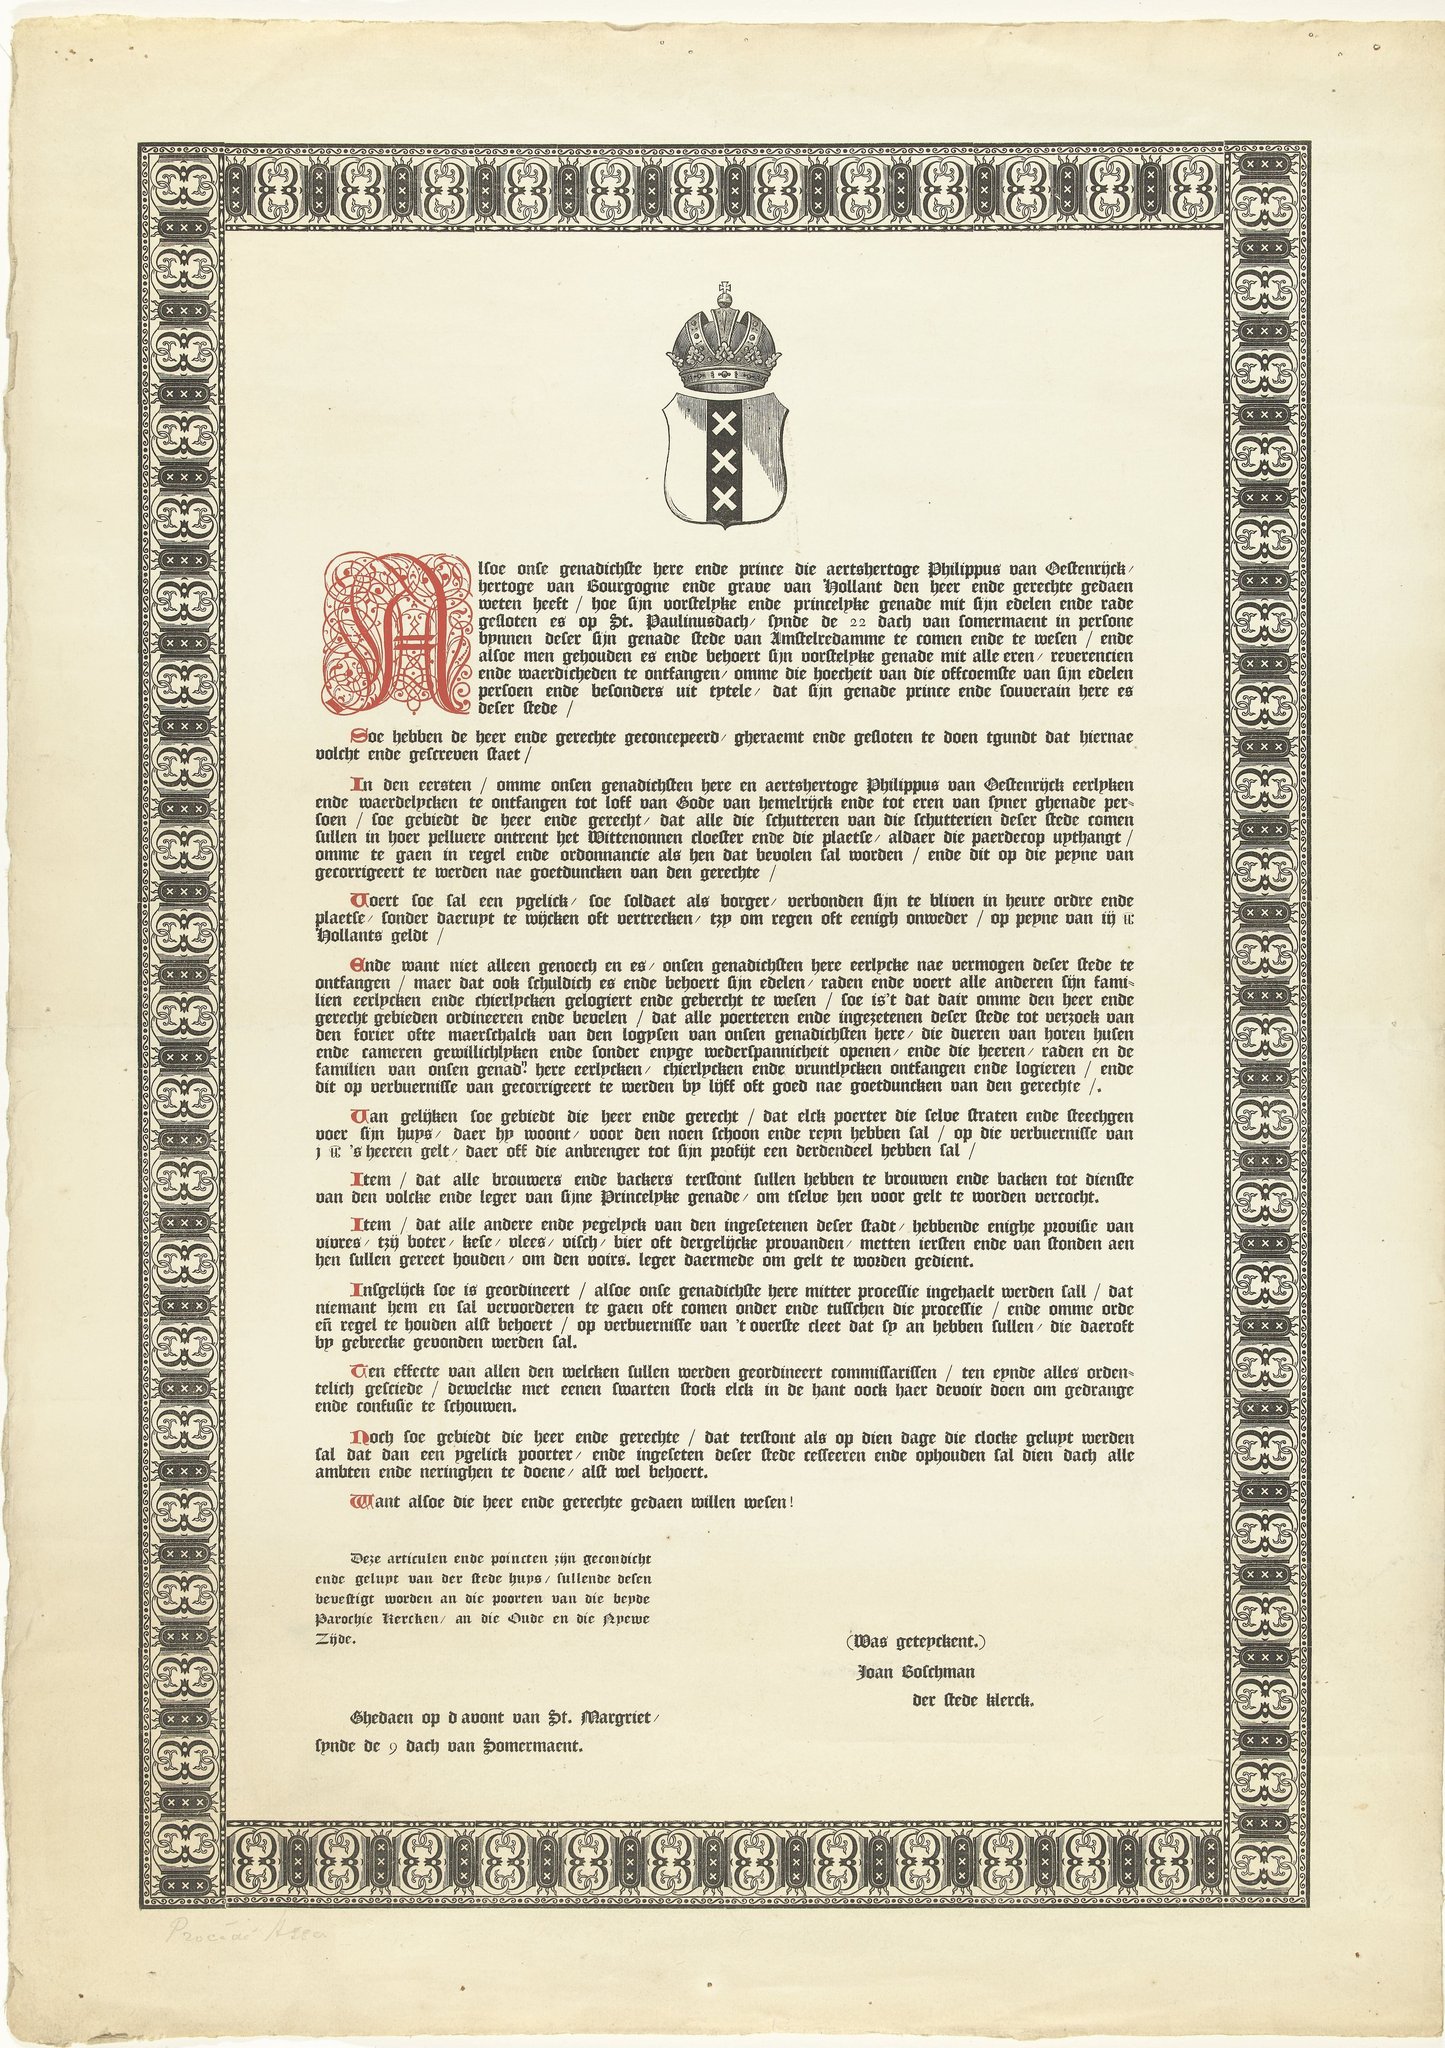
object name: photograph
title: Proclamatie van de stad Amsterdam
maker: a. kroon (fotograaf)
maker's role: fotograaf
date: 1860-1890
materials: paper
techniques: photolithography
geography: netherlands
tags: announcement, proclamation of laws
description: Reproductie volgens het fotolithografisch procédé Asser. Proclamatie met een regelement voor de inwoners van de stad Amsterdam over hoe men dient te handelen bij de komst van Filips de Schone, hertog van Bourgondië opgesteld door Joan Boschman in de functie van stadsklerk.